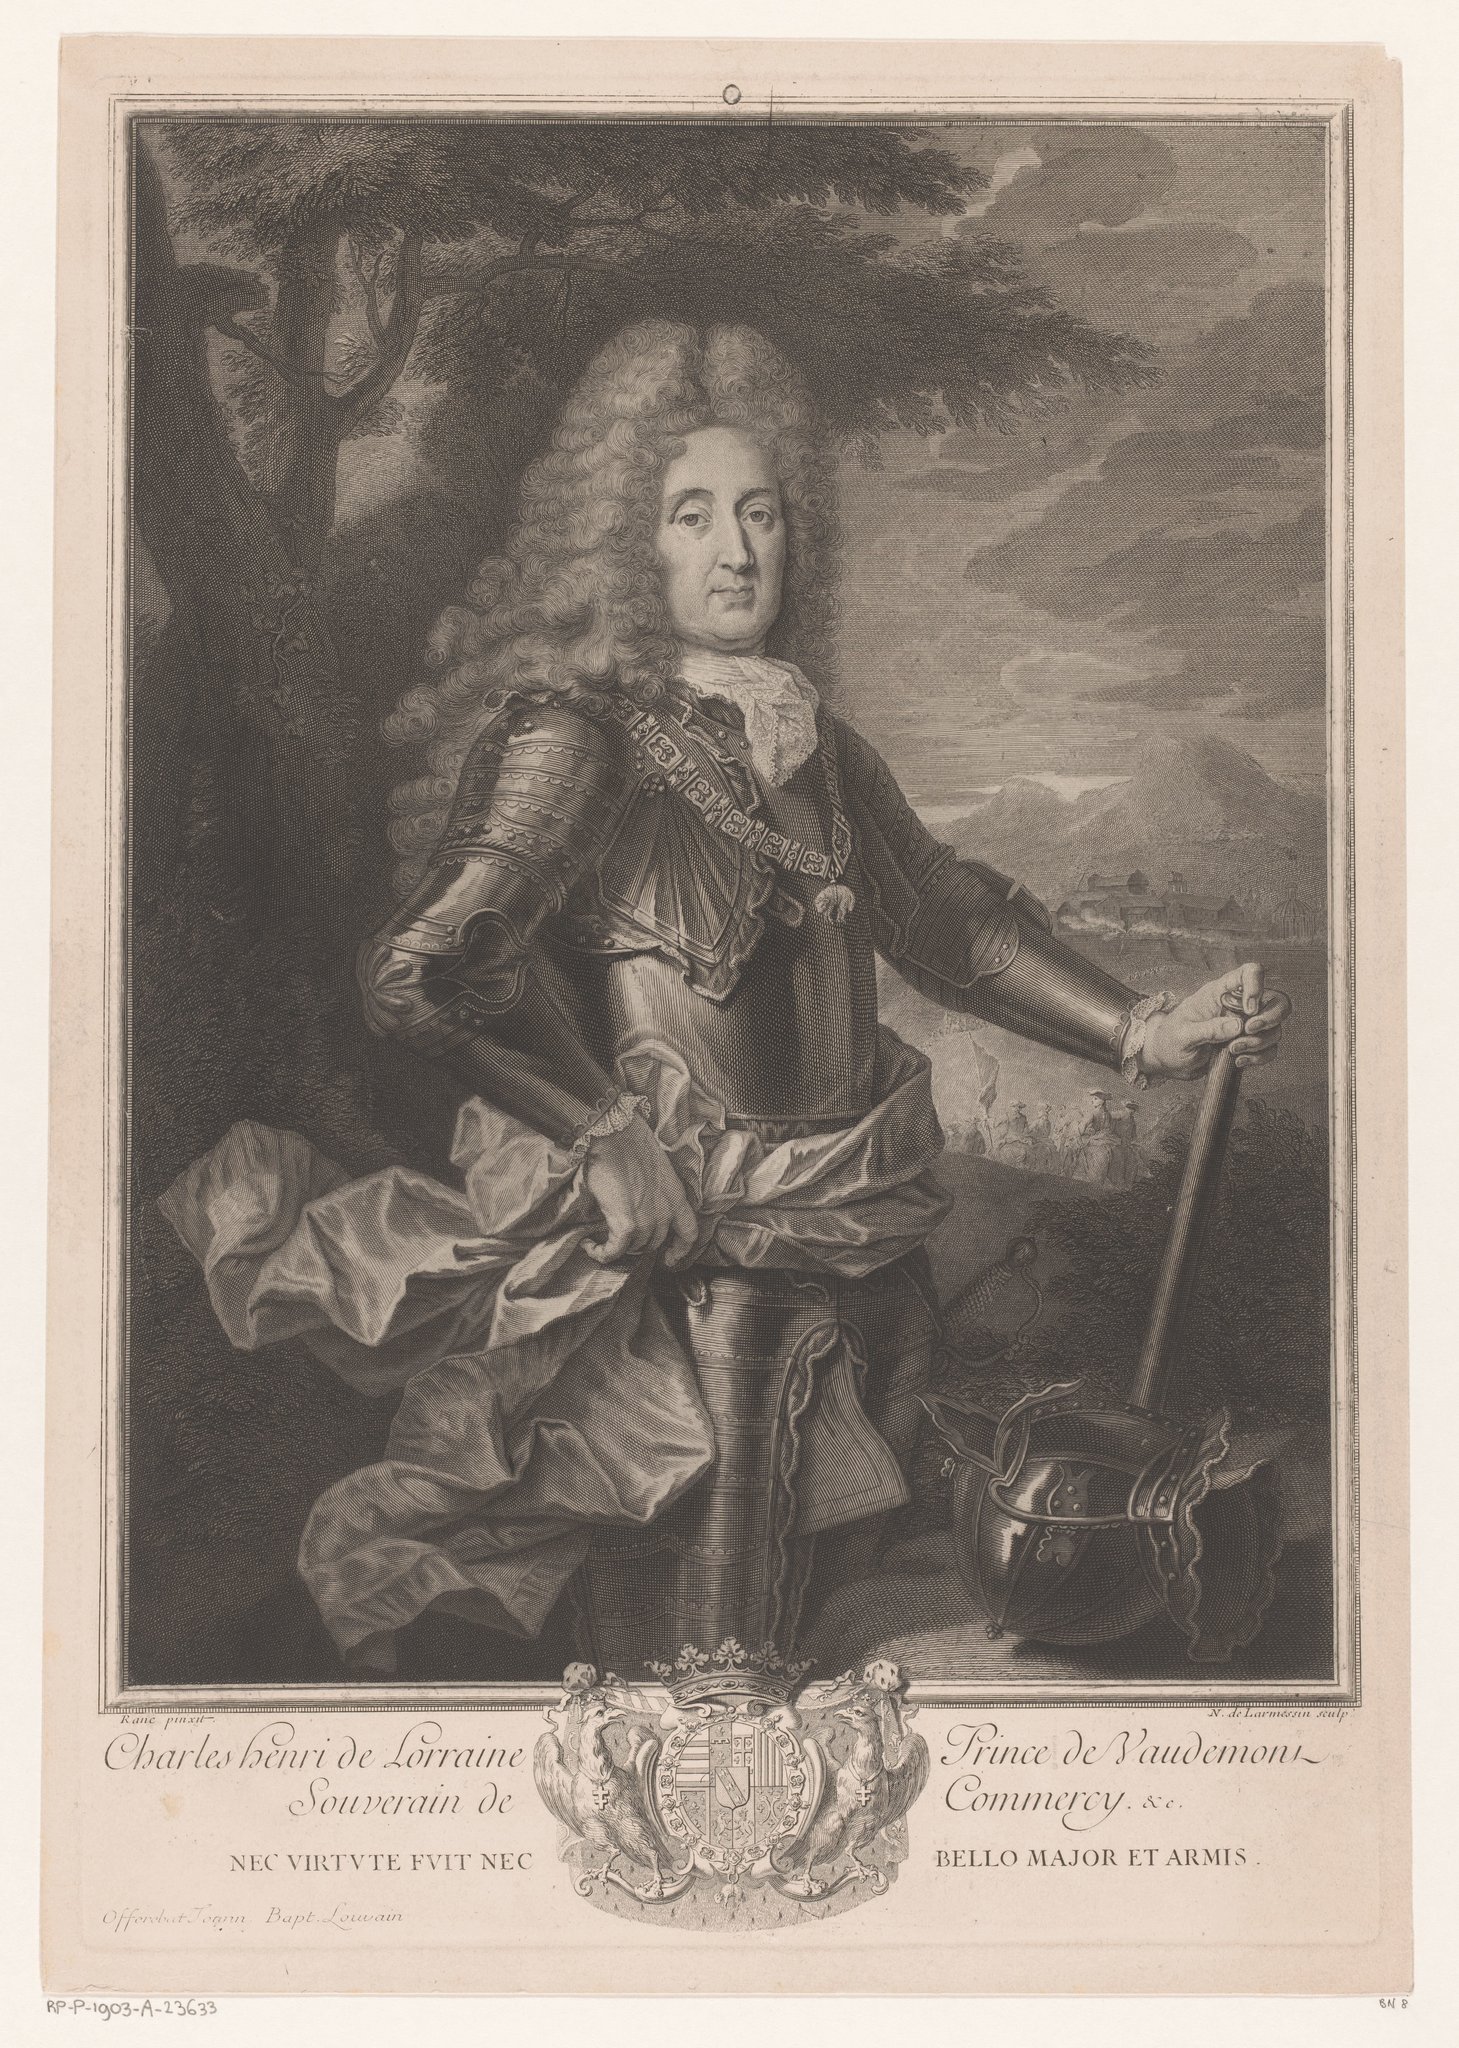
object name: print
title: Charles Henri de Lorraine (...)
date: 1694-1755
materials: paper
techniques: engraving, etching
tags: brussels, historical persons, warfare; military affairs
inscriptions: collector's mark: Lugt 2228